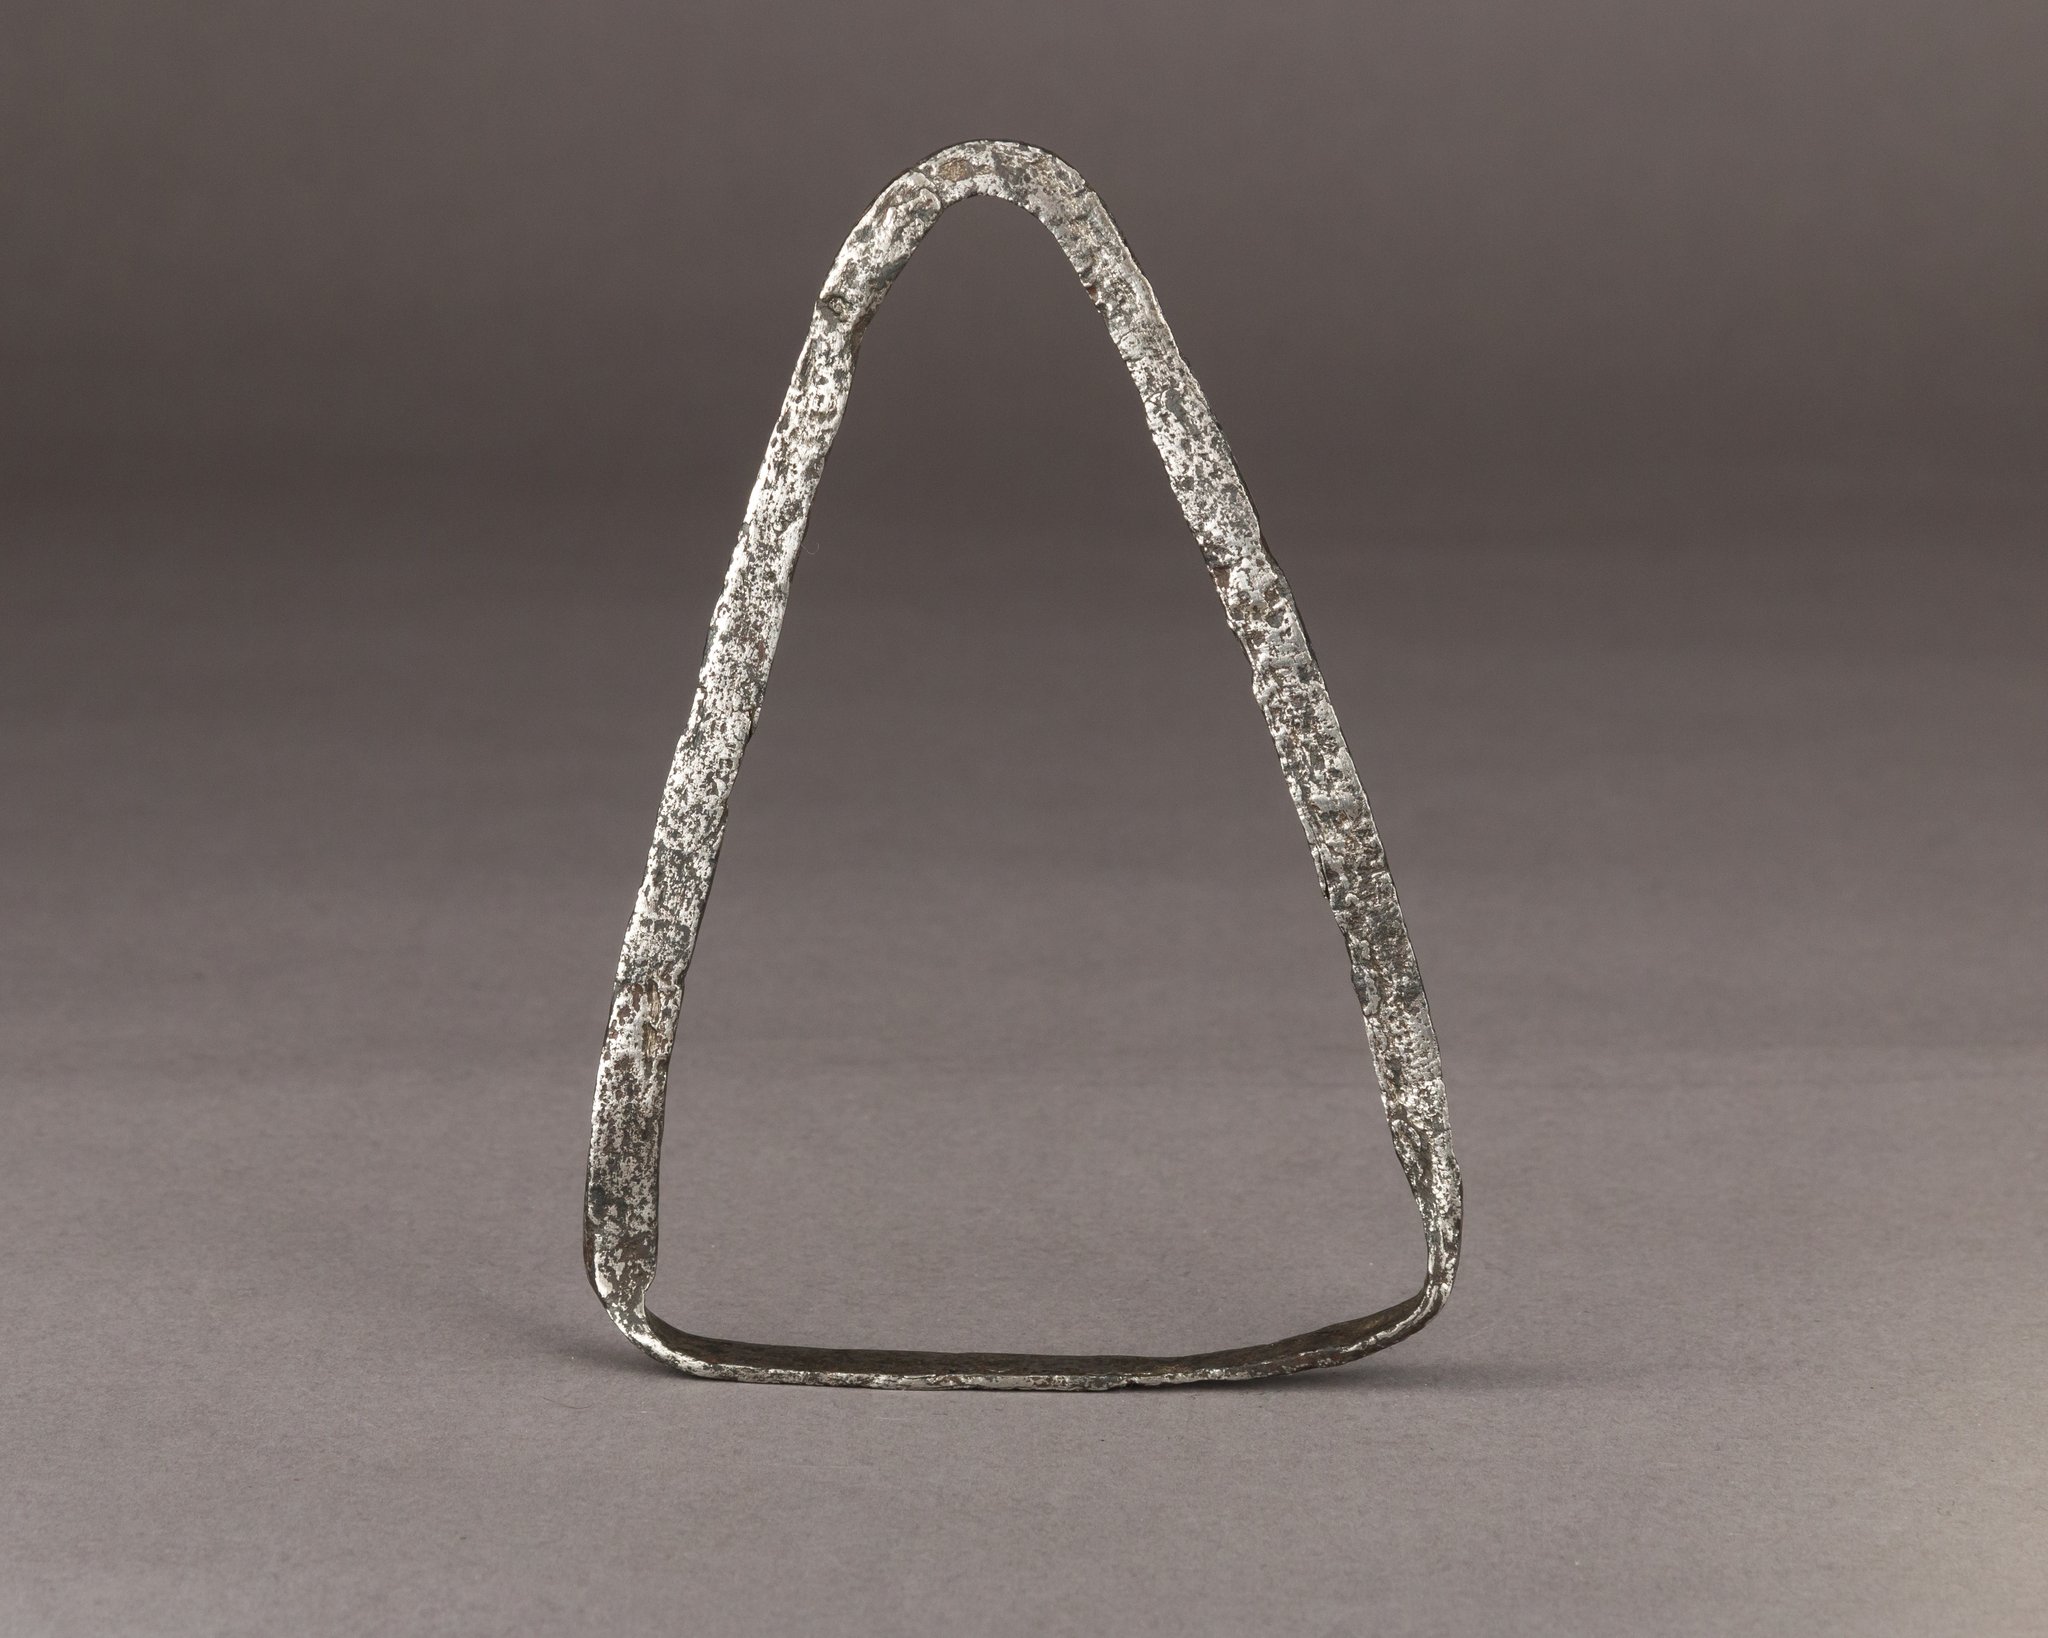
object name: stirrup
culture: german or west slavic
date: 801-1000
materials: iron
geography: poland